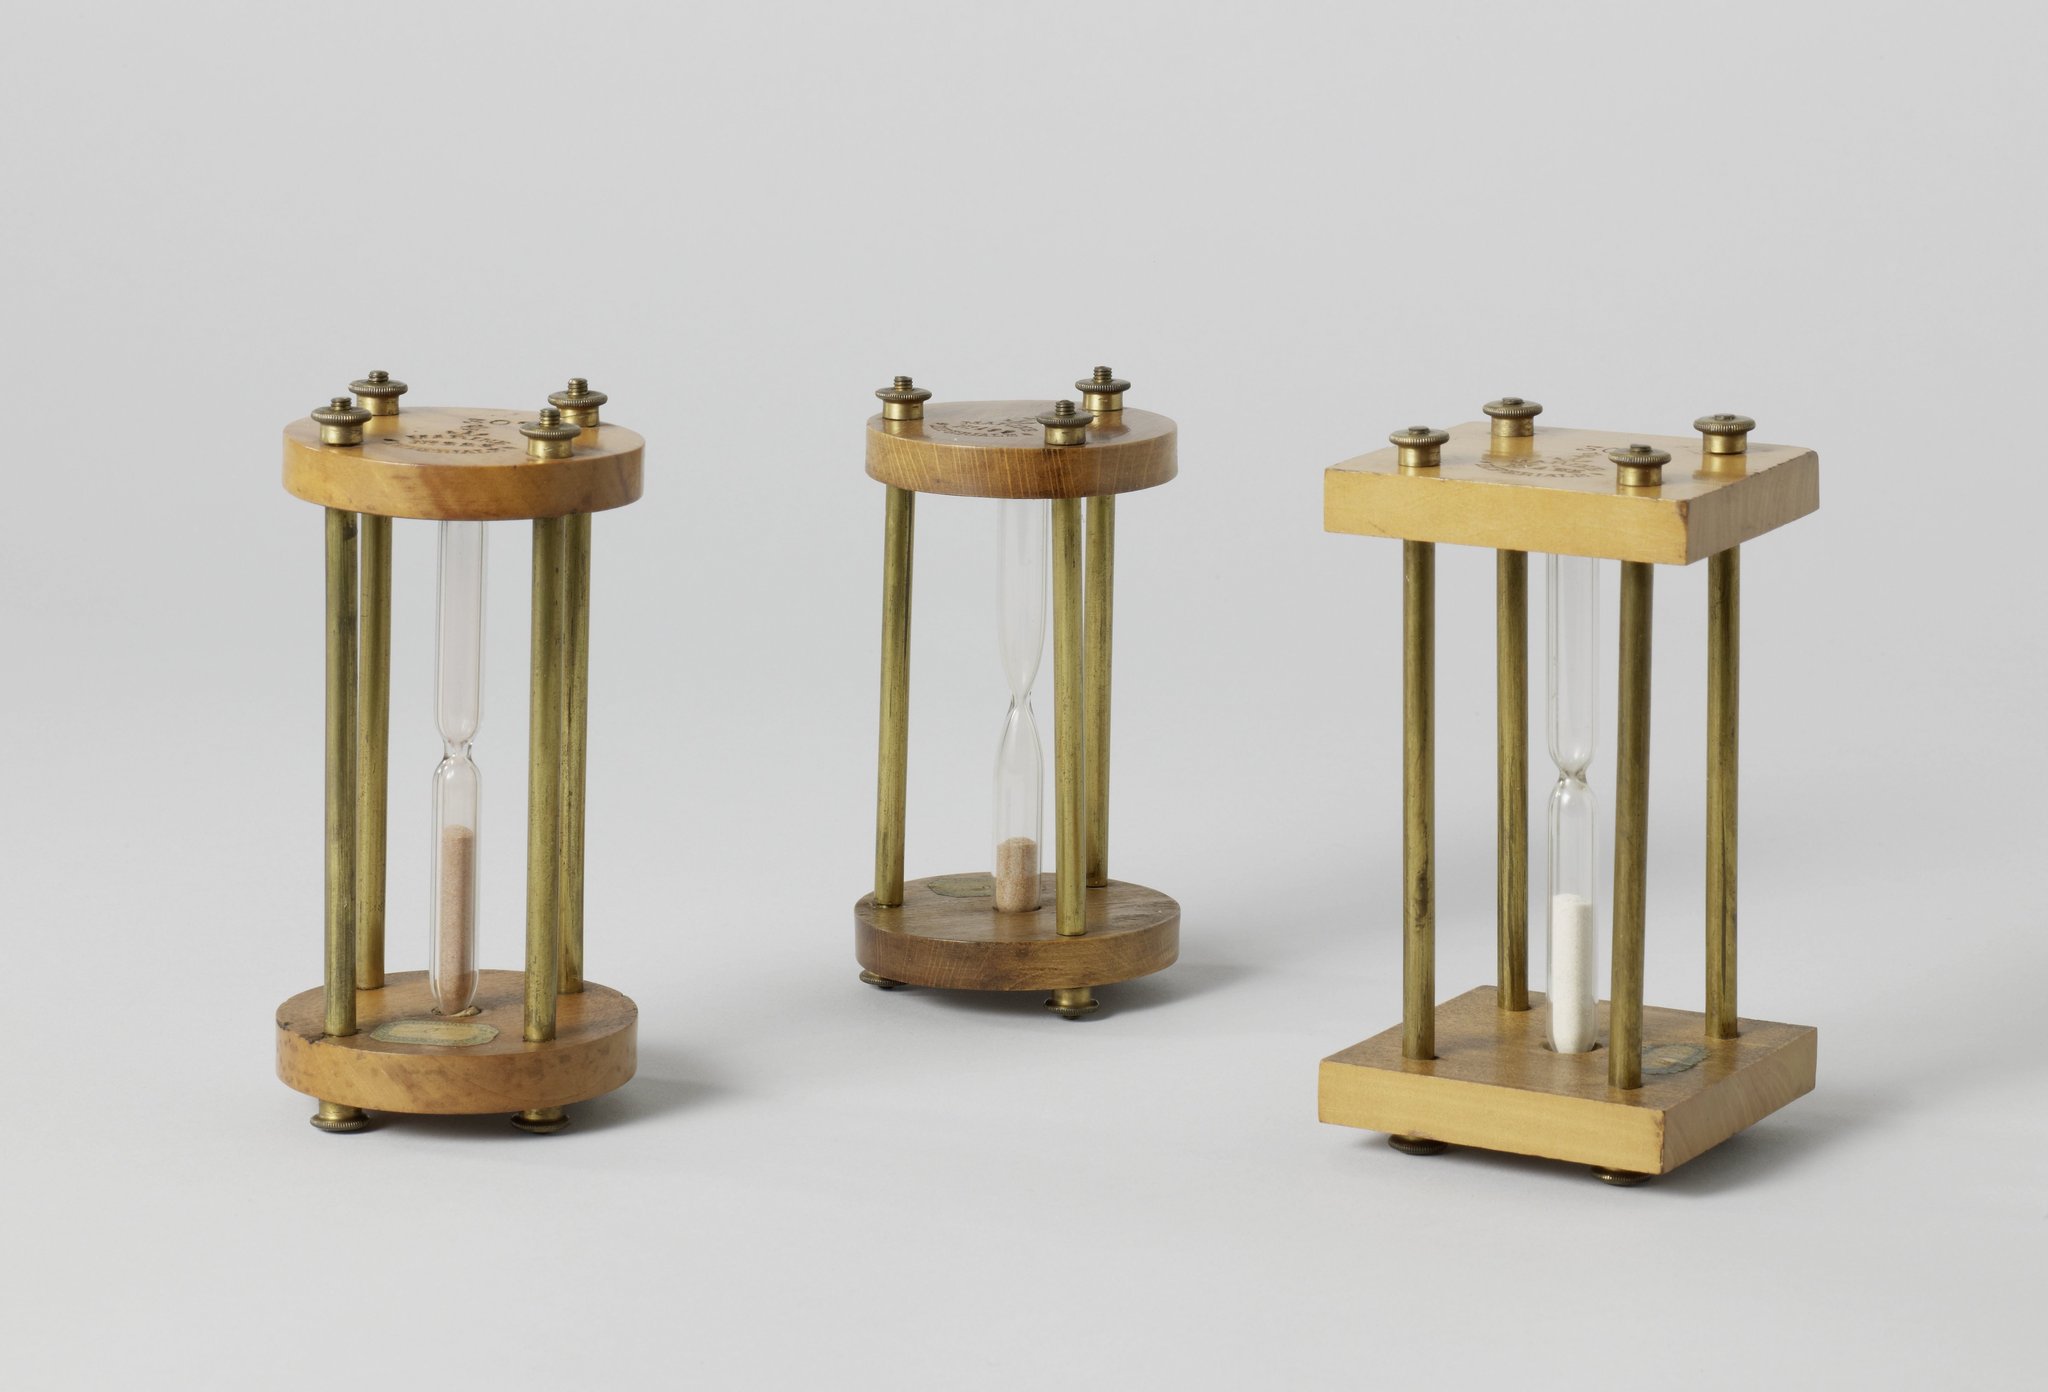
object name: sand glass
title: Sand Glass of 30 Seconds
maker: Anonymous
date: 1860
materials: brass, cork, glass, mineral, wood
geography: france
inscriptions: inscription, on the top: ‘30 S / MARINE / Nº 223 / IMPERIALE’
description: De zandloper is gemonteerd tussen houten plaatjes die bijeengehouden worden door messing bouten.